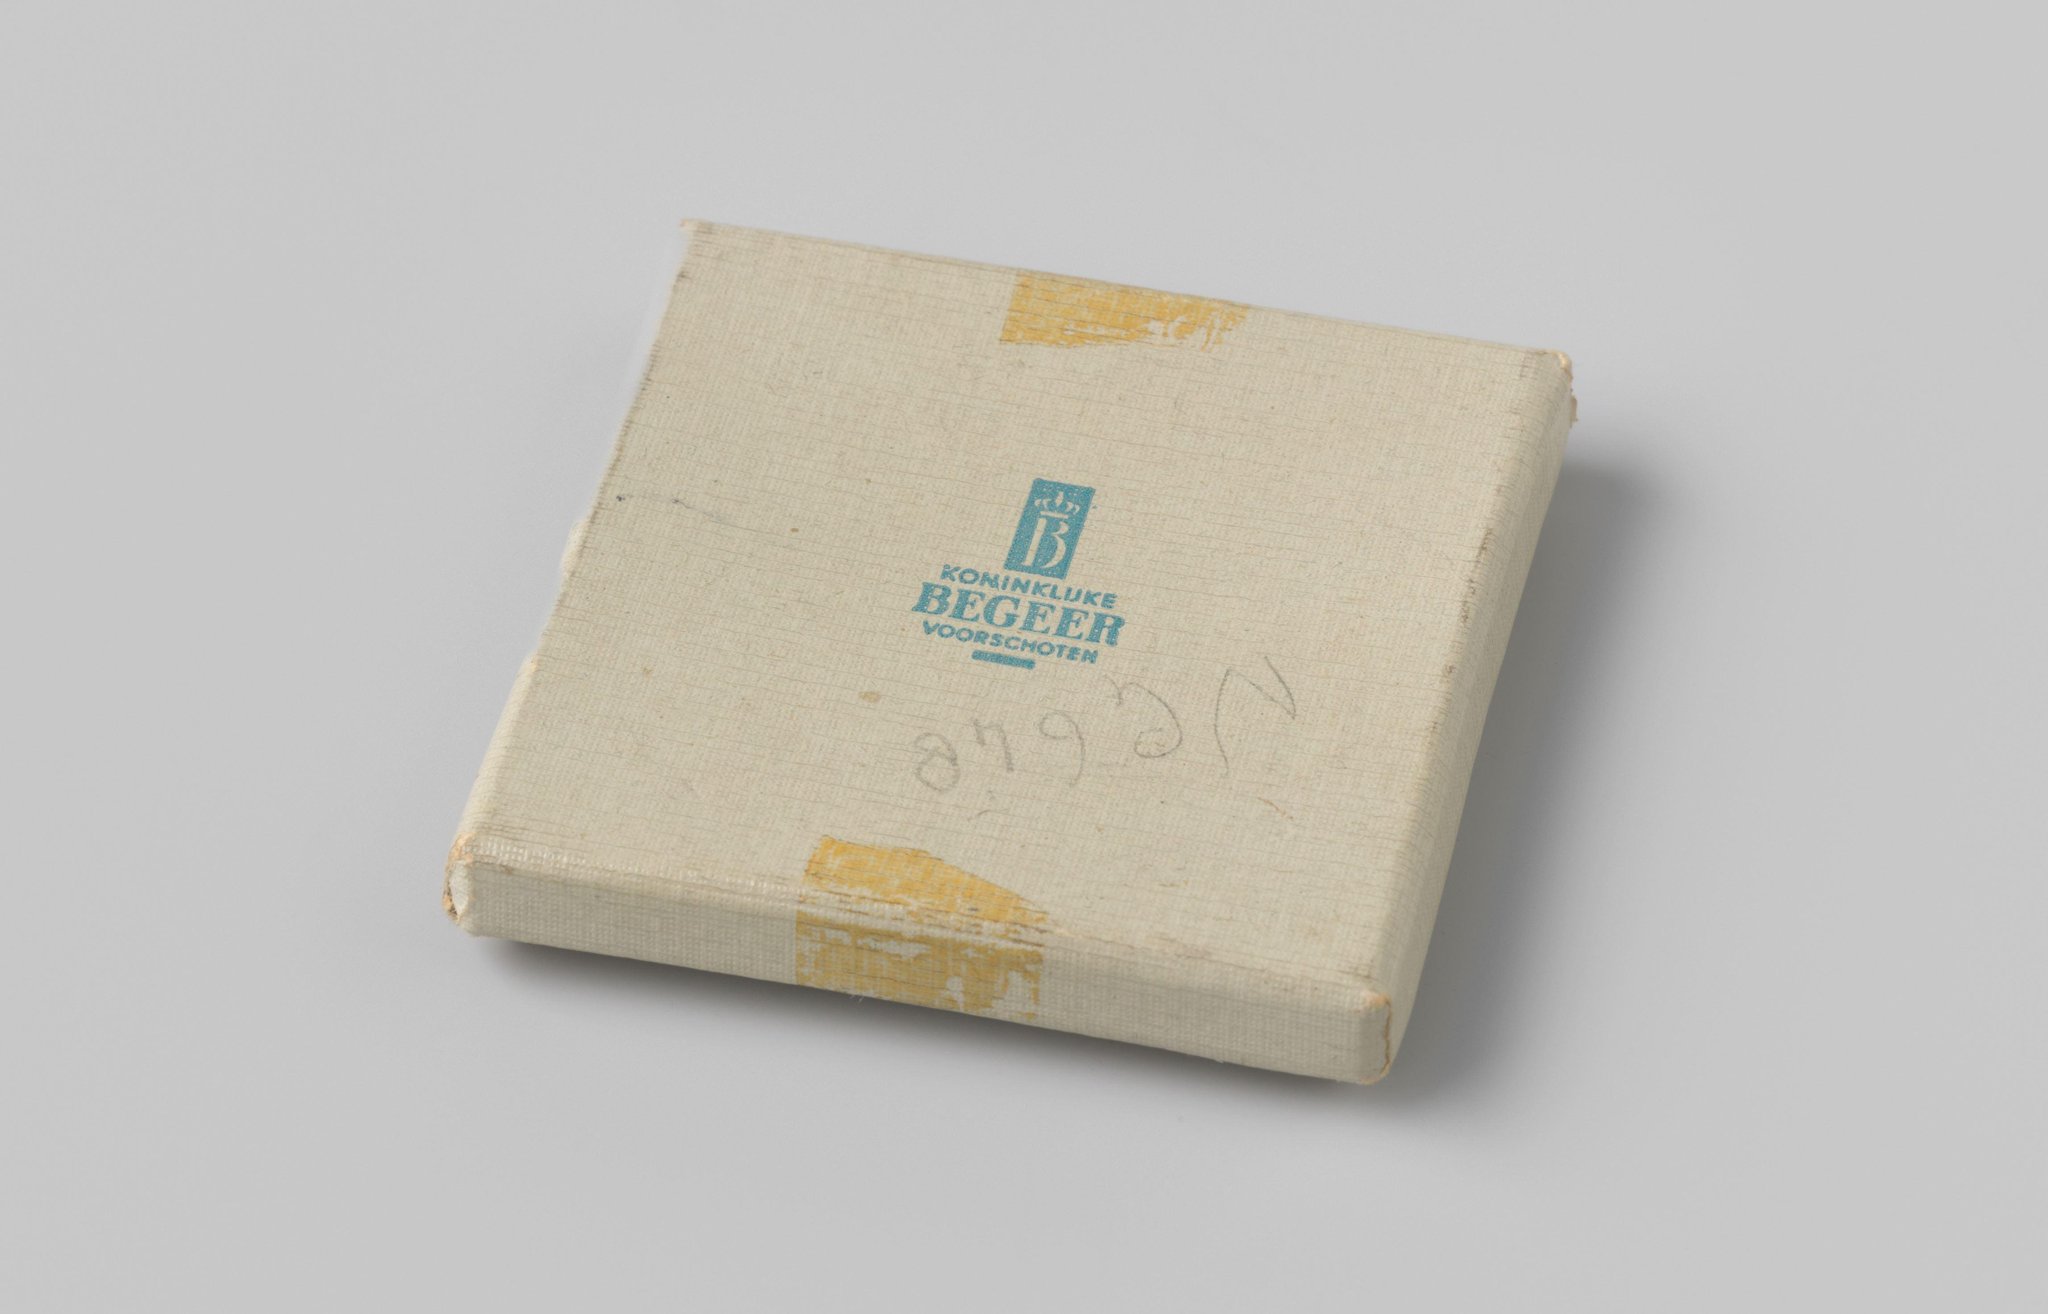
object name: box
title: Doos behorend bij een bronzen penning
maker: arie van wijnen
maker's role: medailleur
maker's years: 1901-1971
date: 1965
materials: cardboard, velvet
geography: voorschoten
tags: rijksmuseum amsterdam